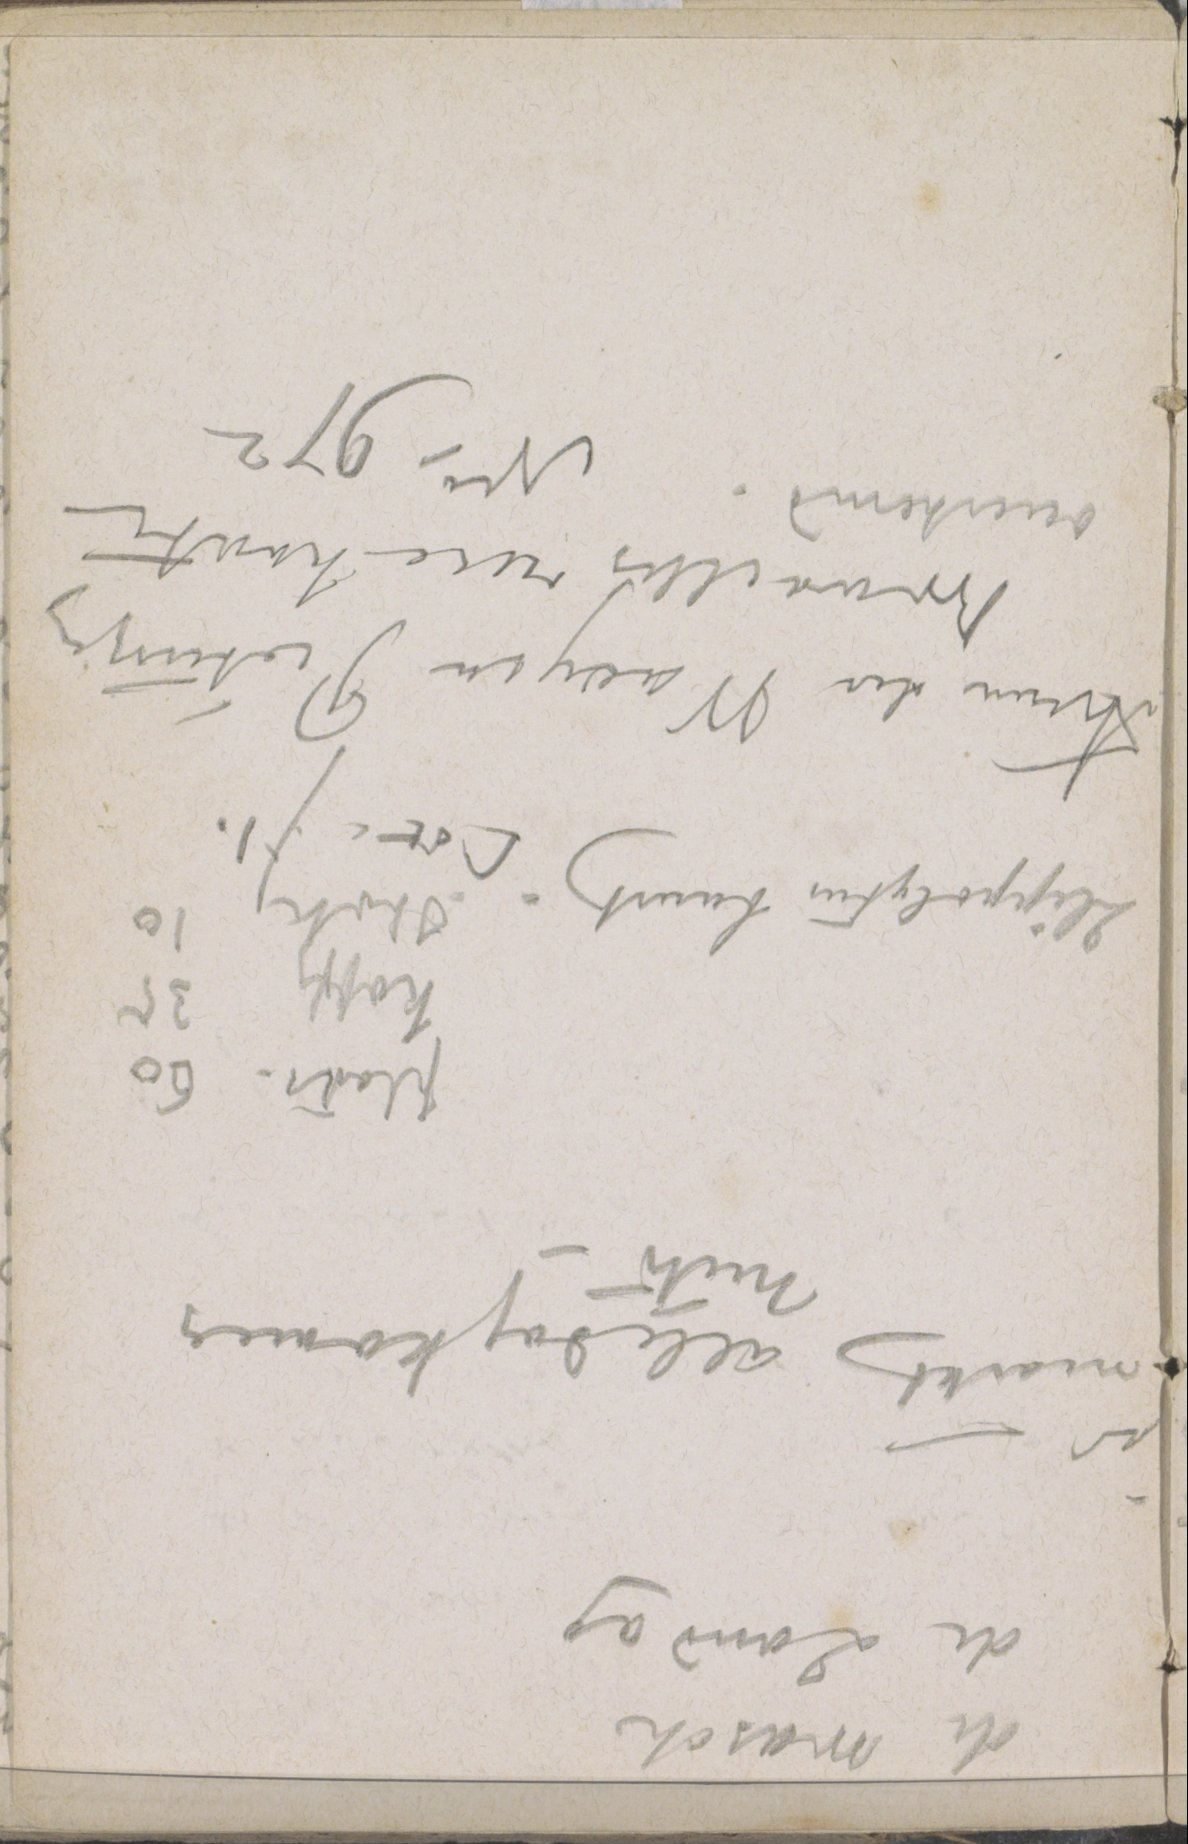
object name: sketchbook leaf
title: Notities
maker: johannes tavenraat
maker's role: draughtsman, painter, print maker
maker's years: 1809-1881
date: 1862-1864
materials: paper, pencil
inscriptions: annotation: ‘[...]’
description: Blad 60 verso uit een schetsboek met 65 bladen.